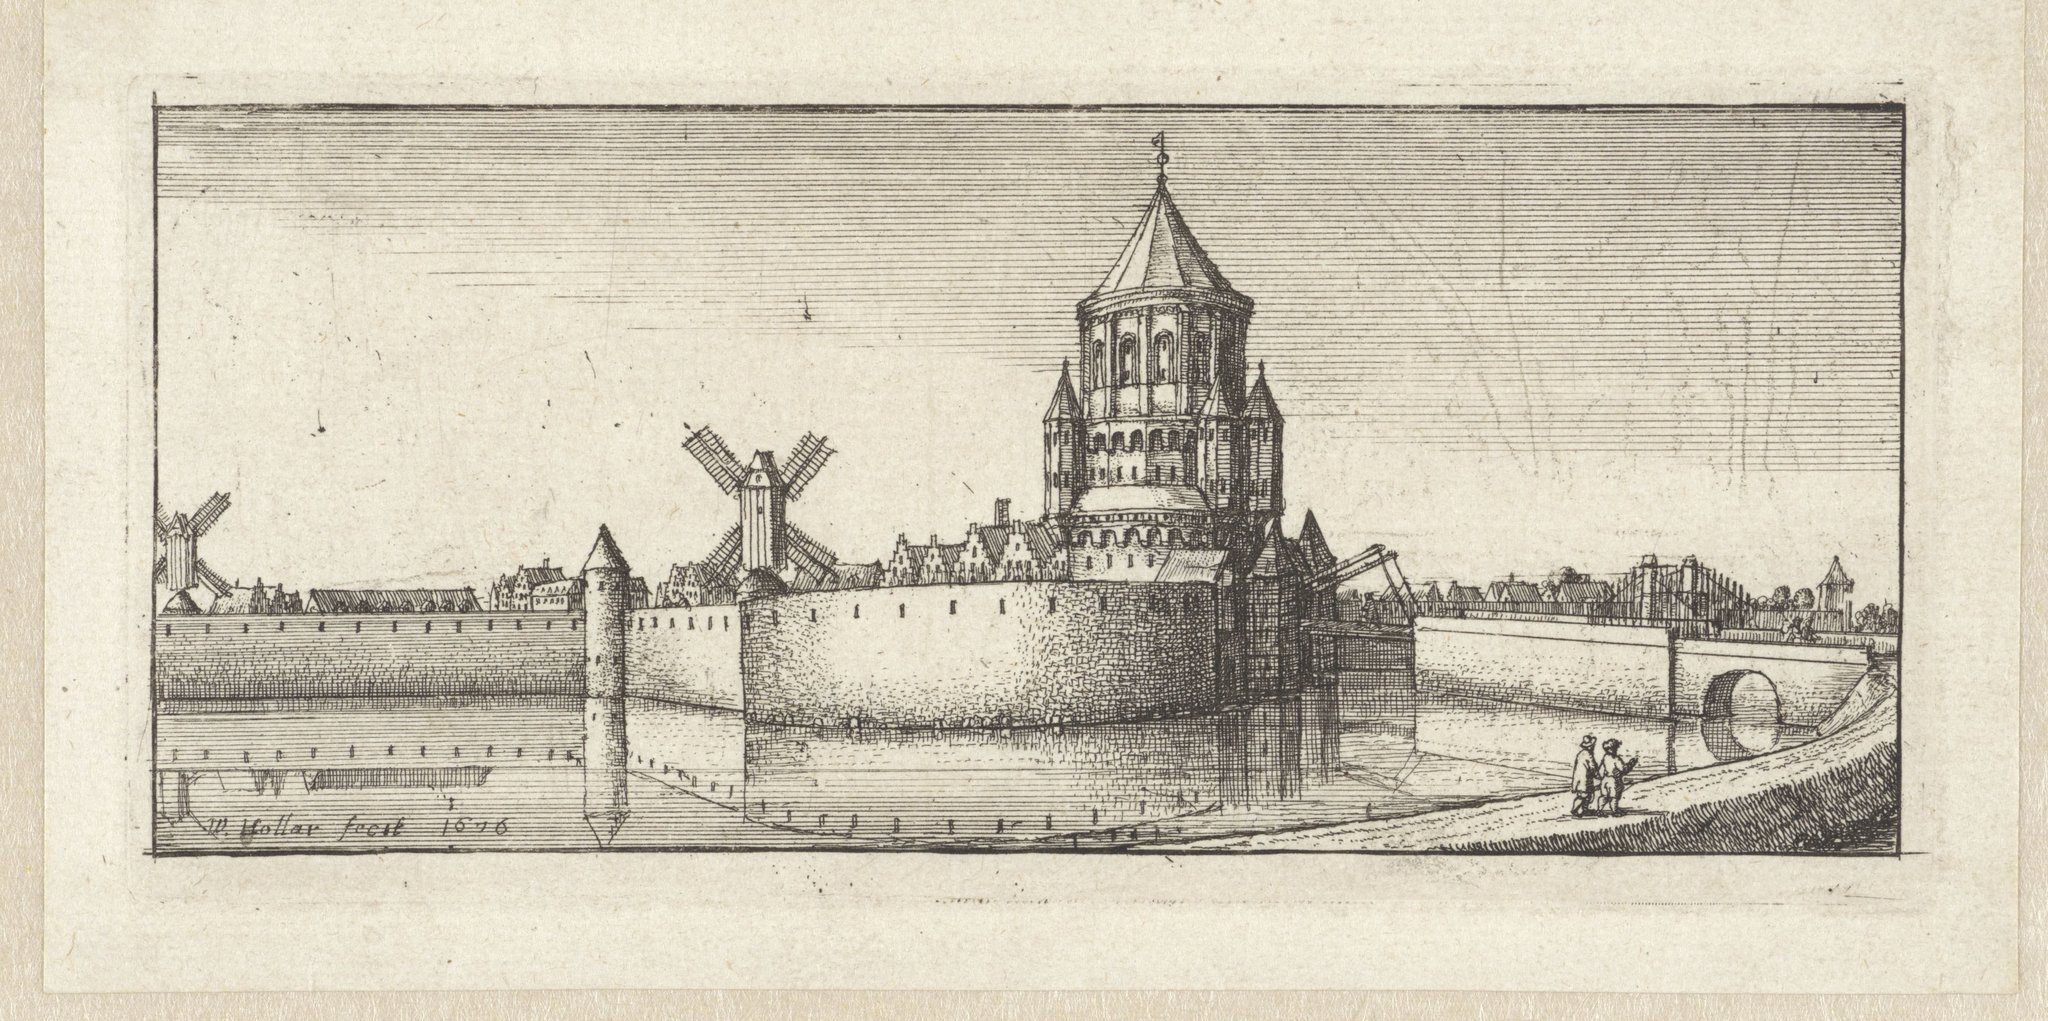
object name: print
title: Gezicht op de Kleine Houtpoort te Haarlem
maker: wenceslaus hollar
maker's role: draughtsman, print maker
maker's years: 1607-1677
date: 1676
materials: paper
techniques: etching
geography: london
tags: city-gate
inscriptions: collector's mark: Lugt 2228, collector's mark: Lugt 2760